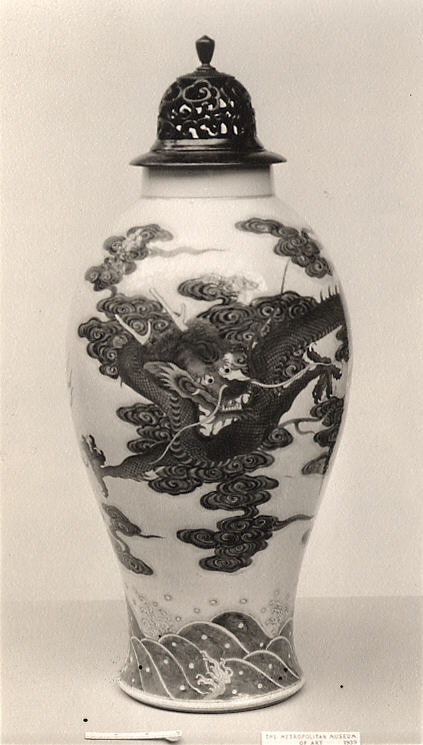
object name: vase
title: Vase with dragon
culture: chinese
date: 1767-1800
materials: cobalt, enamel, porcelain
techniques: overglaze, painting, underglaze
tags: dragons